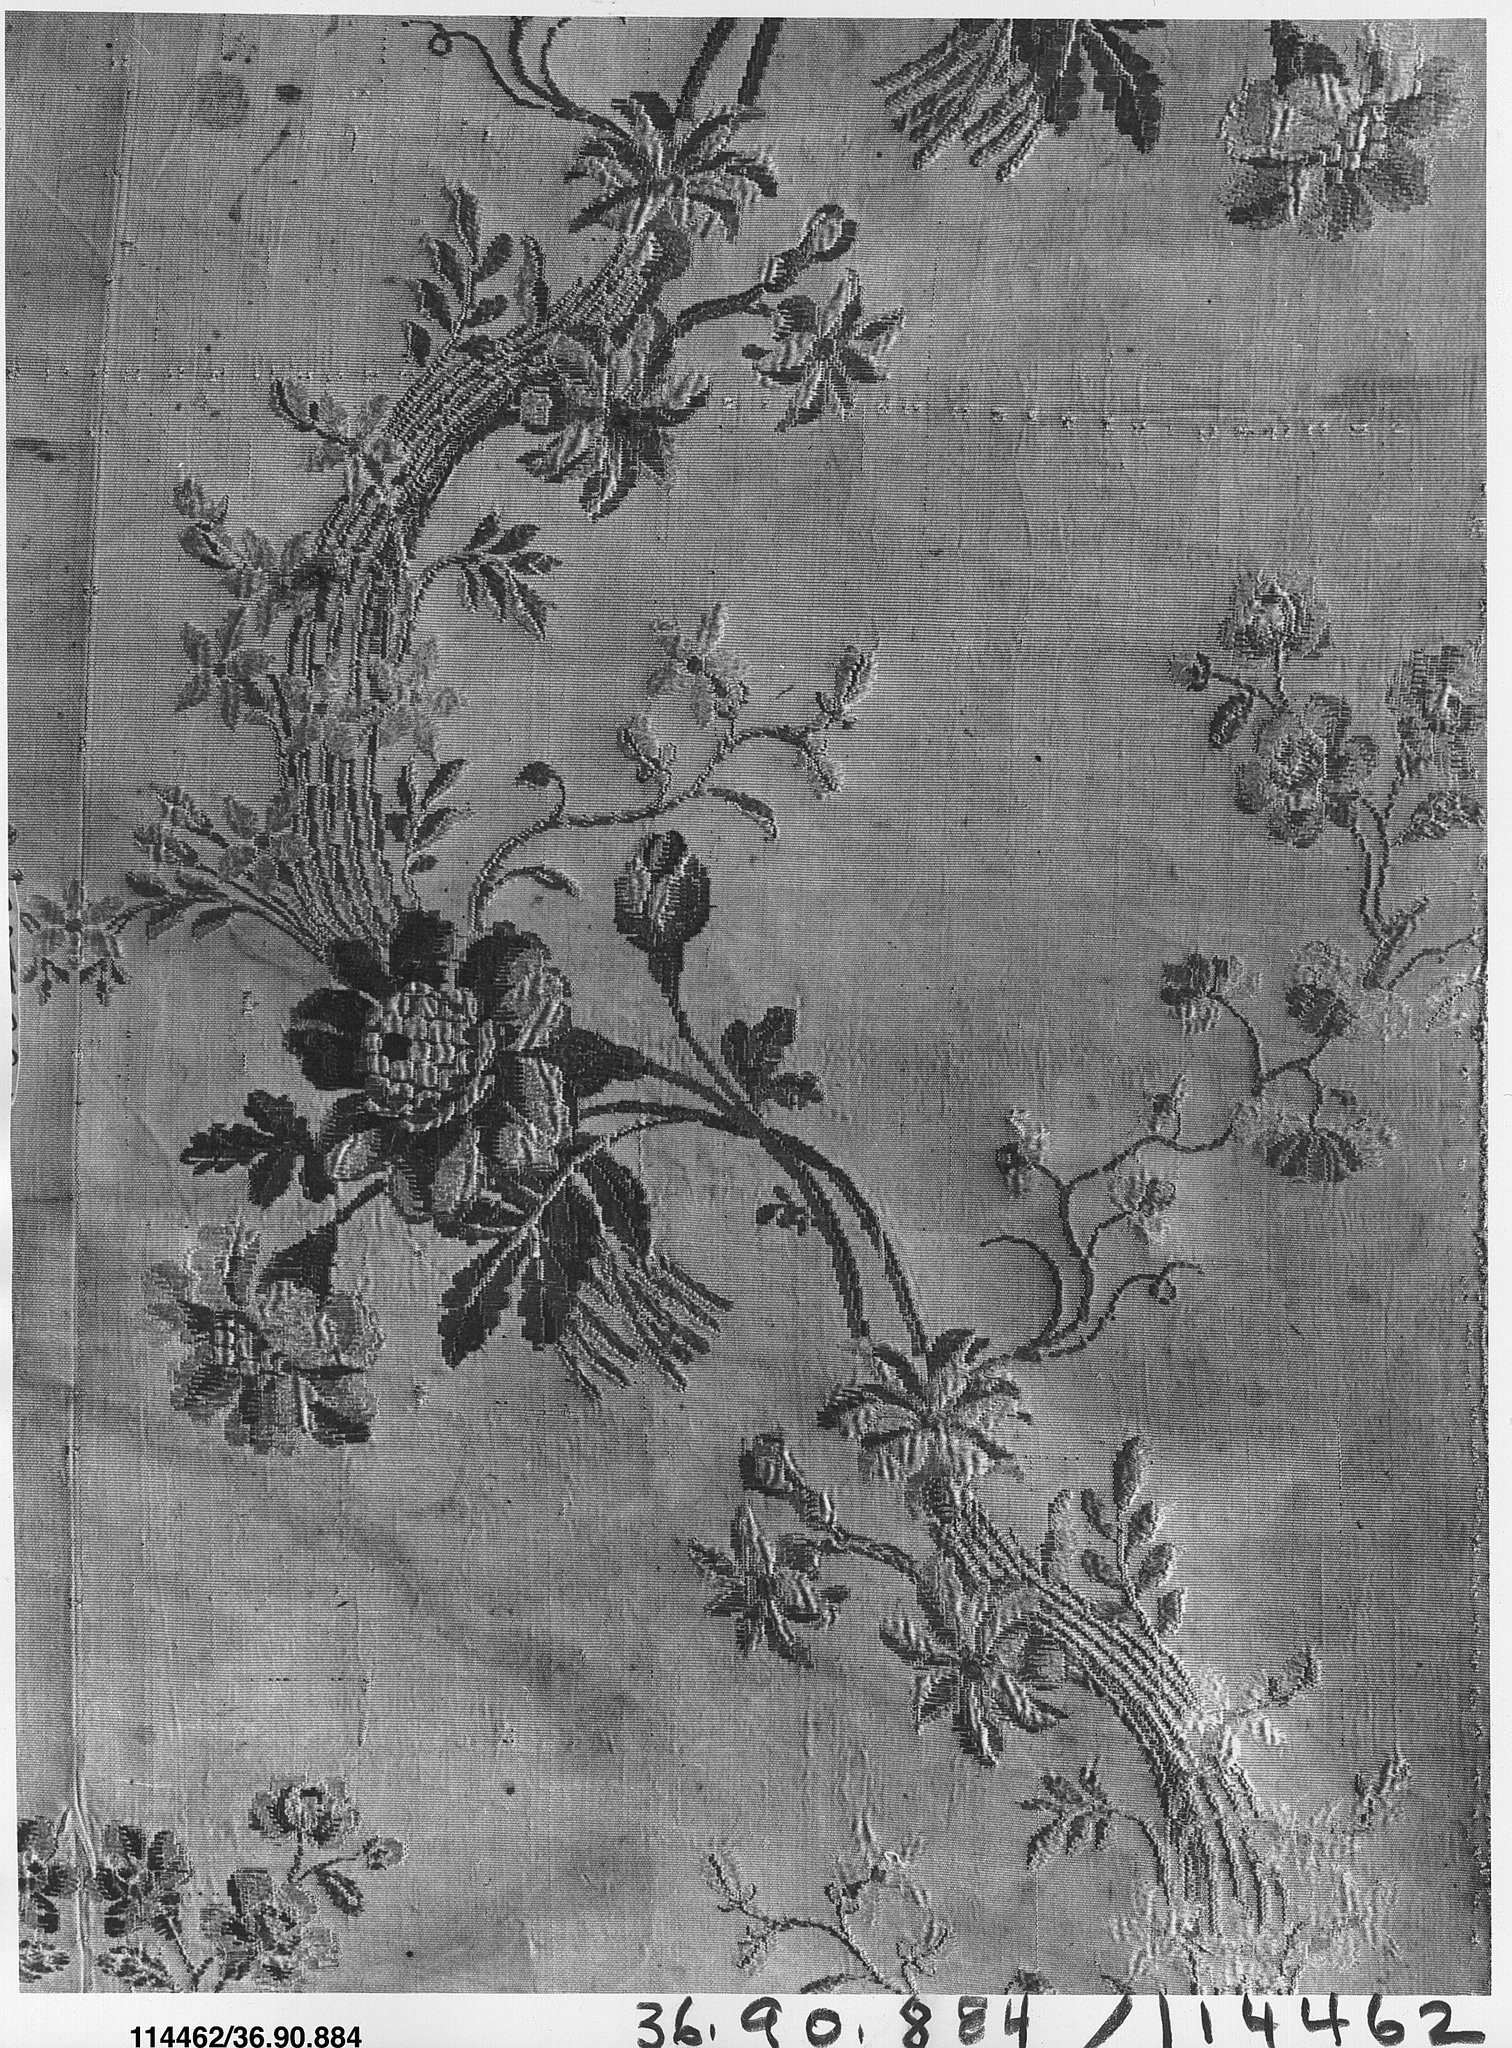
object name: piece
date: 1750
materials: silk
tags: flowers,leaves